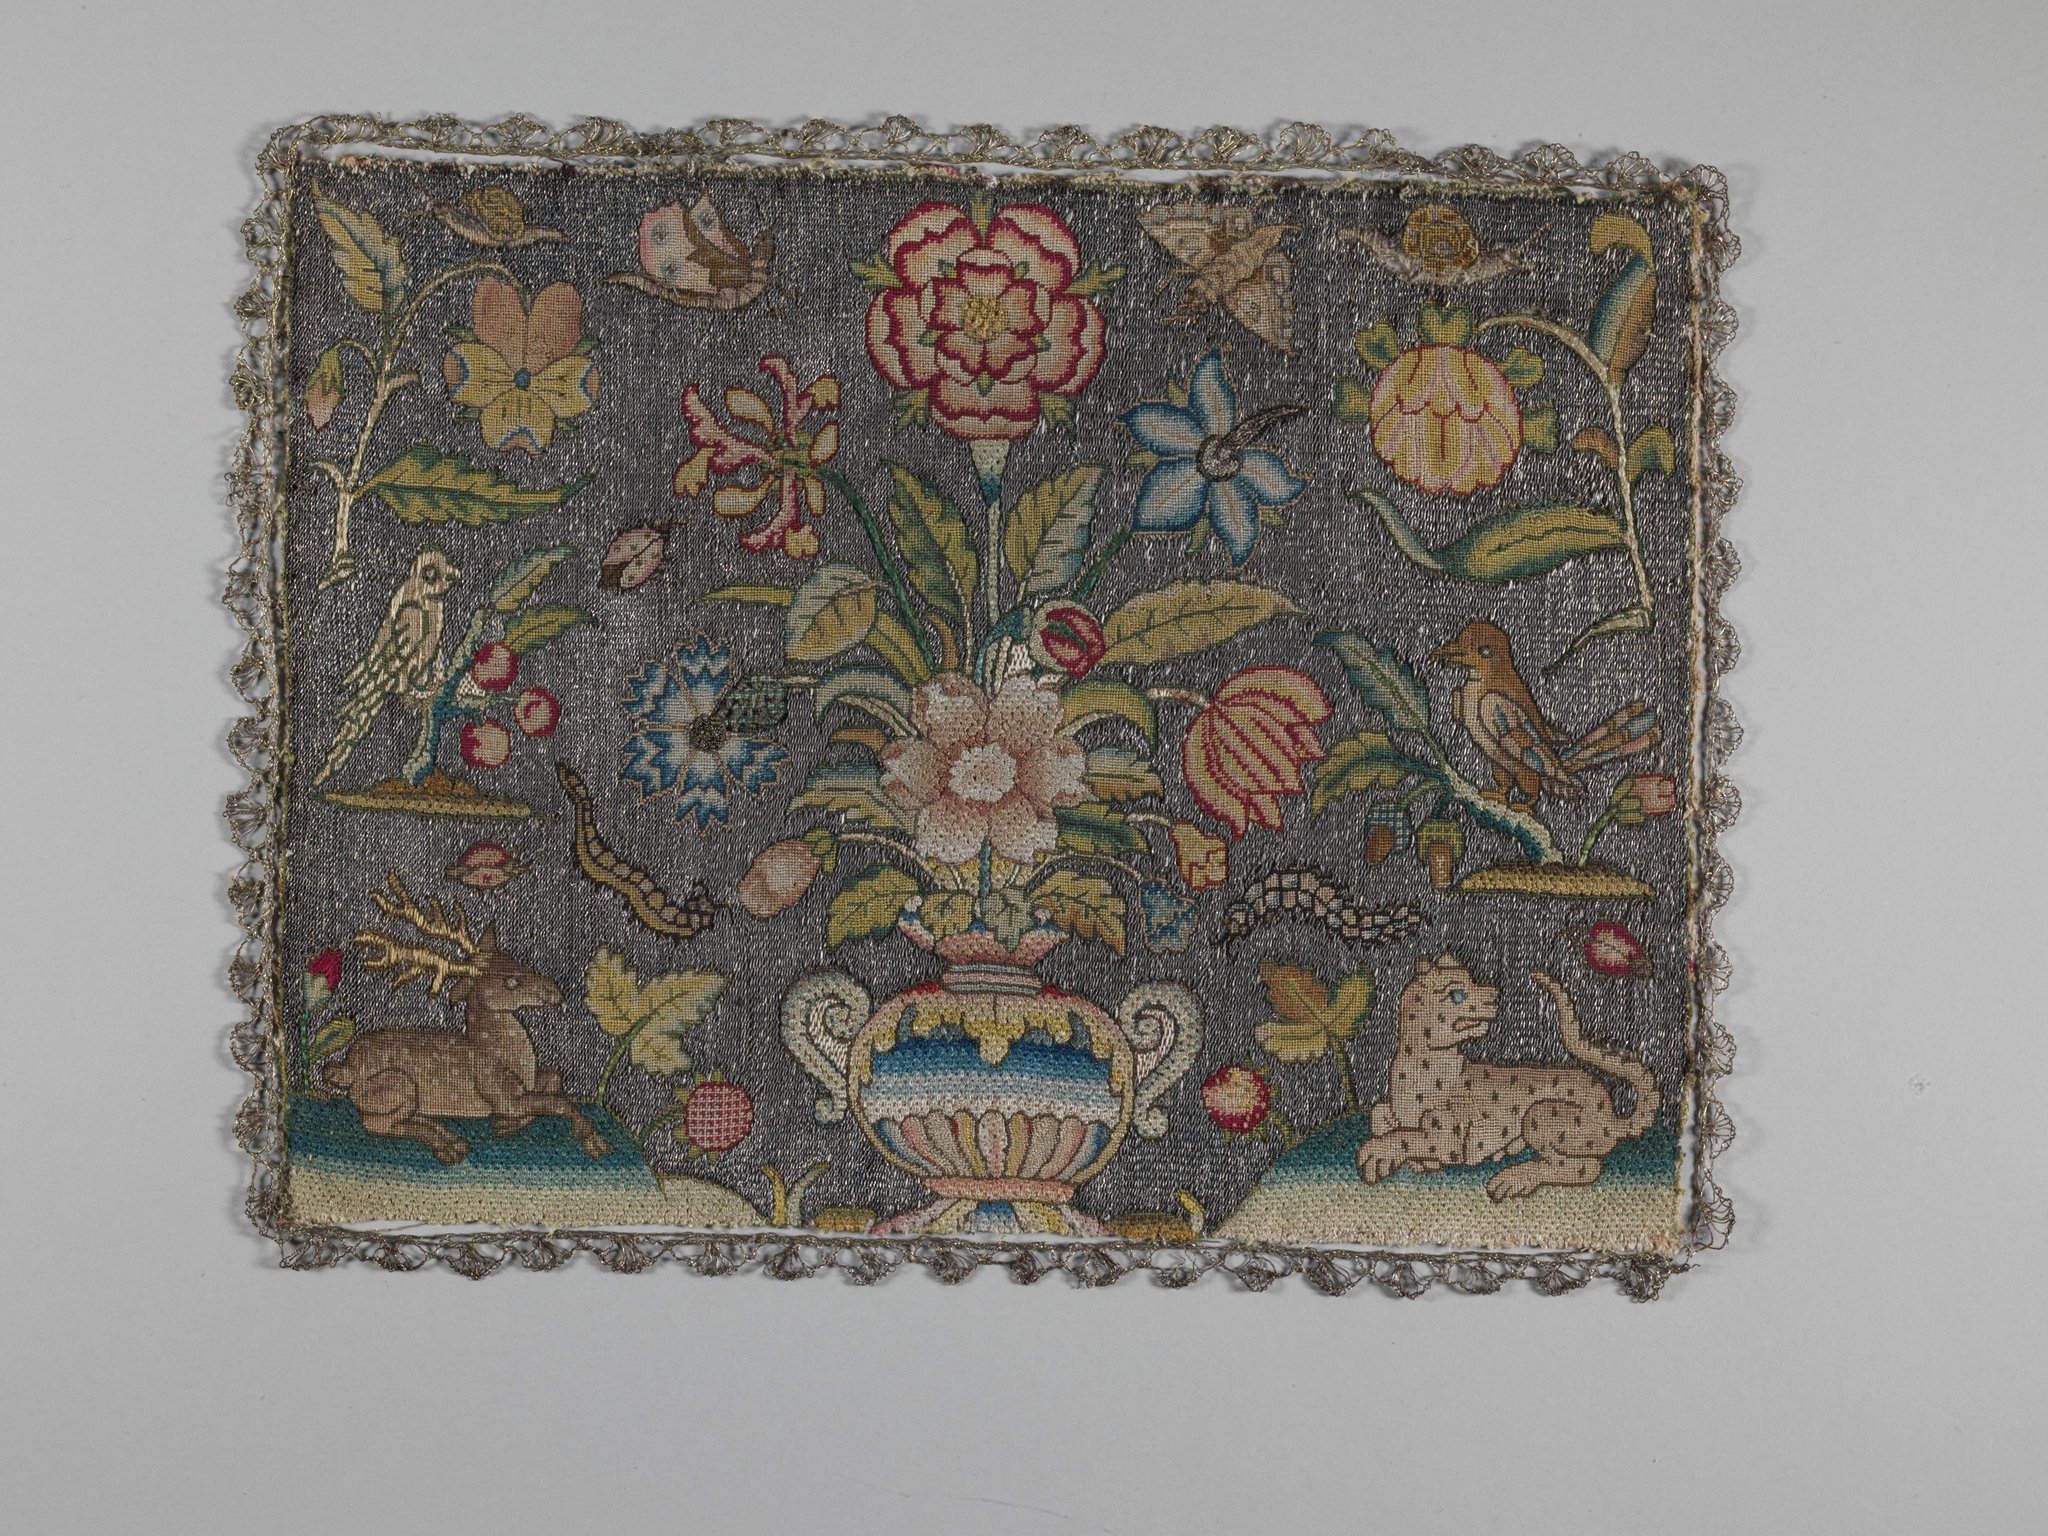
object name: cushion cover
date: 1626-1650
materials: canvas, metal thread, silk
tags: birds,deer,insects,leopards,flowers